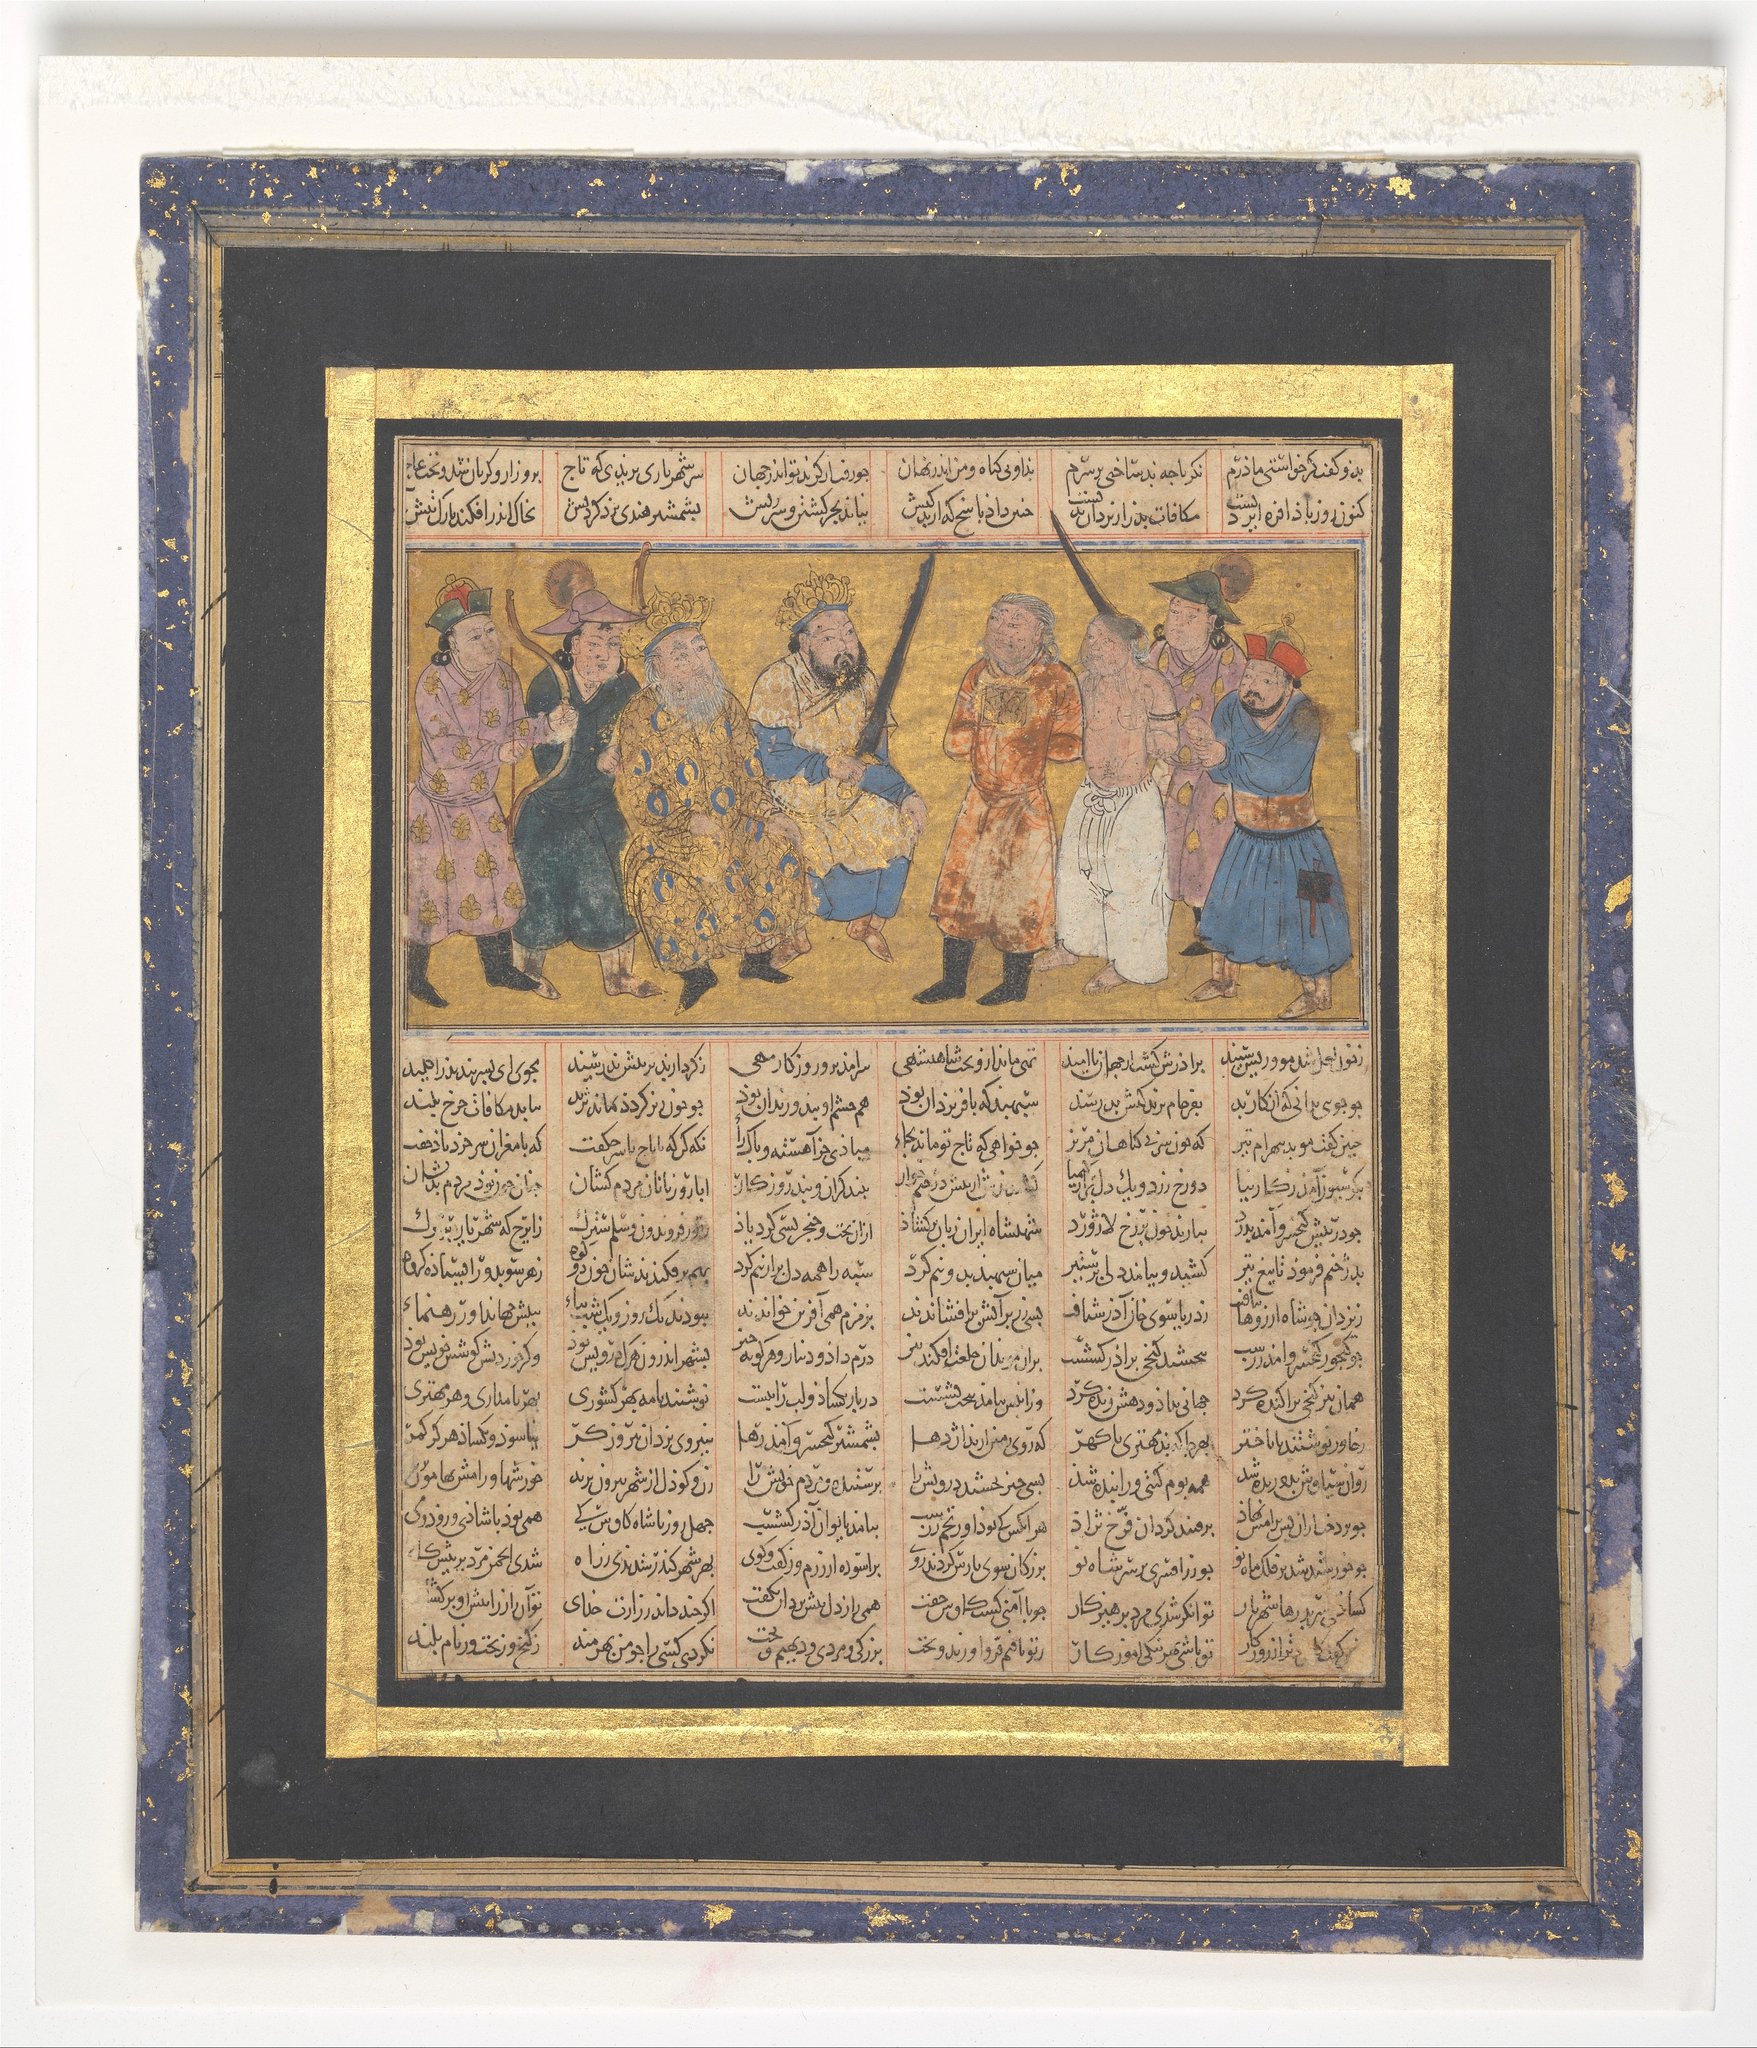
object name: folio from an illustrated manuscript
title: "Kai Khusrau Enthroned Holding a Sword", Folio from the First Small Shahnama (Book of Kings)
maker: abu'l qasim firdausi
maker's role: author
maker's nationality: iranian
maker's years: 935-1020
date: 1300-1330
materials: gold, ink, paper, watercolor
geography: iran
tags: swords,men,execution